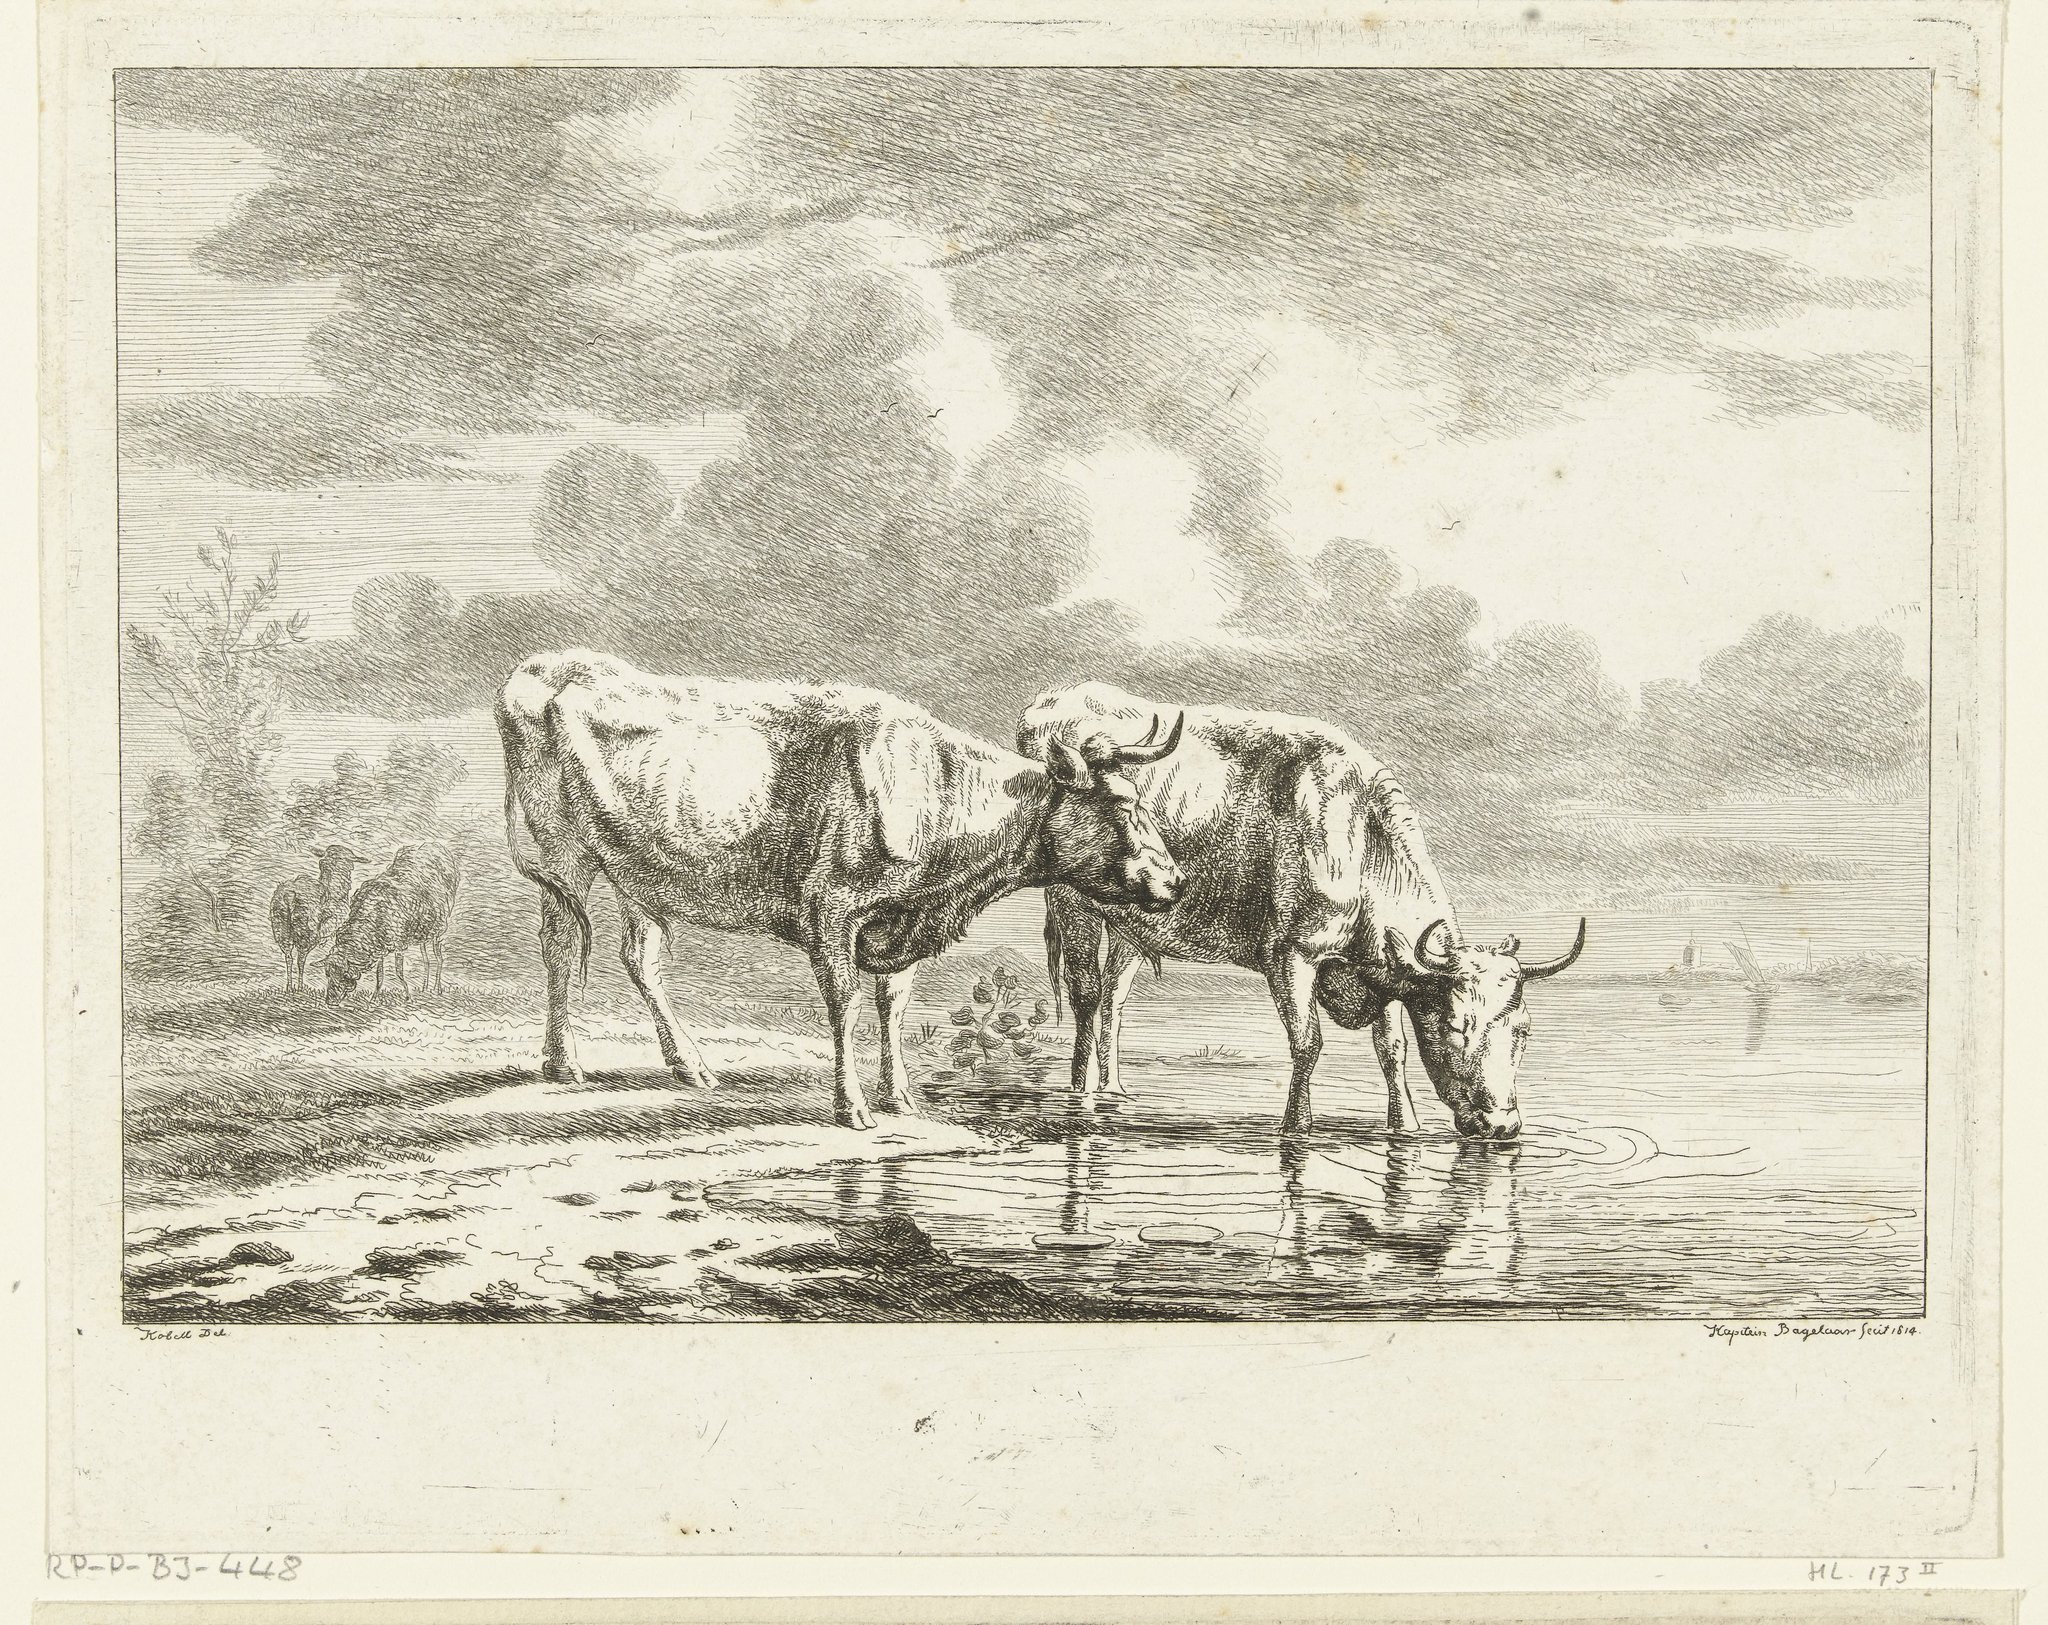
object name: print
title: Twee stieren en twee schapen bij het water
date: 1814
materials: paper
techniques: drypoint, etching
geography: netherlands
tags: sheep, bovine cattle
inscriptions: collector's mark: Lugt 2228